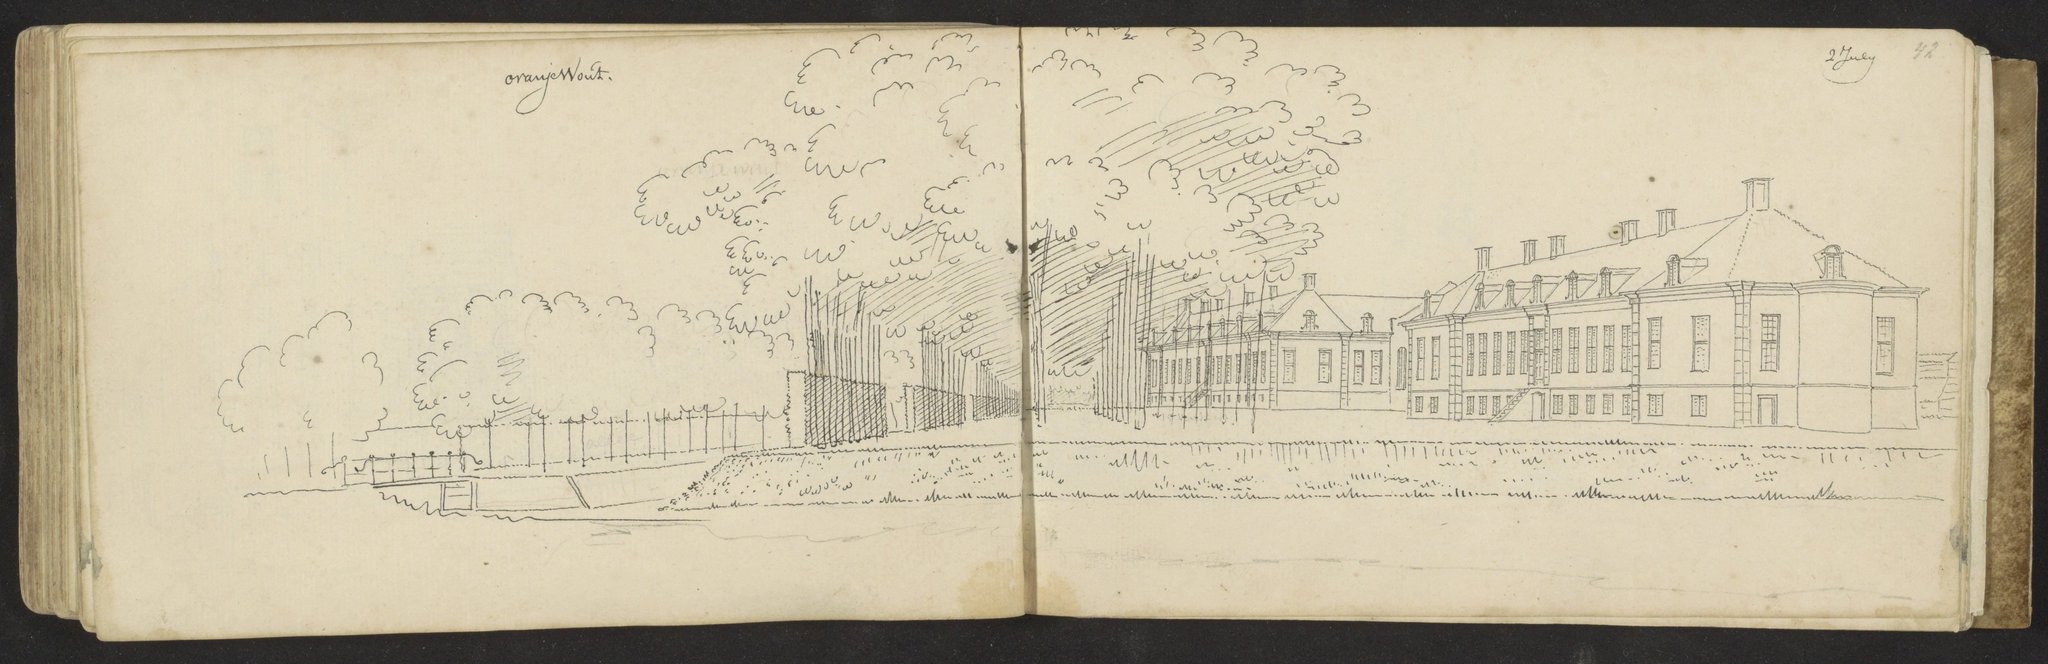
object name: sketchbook leaf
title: Gezicht op landgoed Oranjewoud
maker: abraham de haen (ii)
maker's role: draughtsman, print maker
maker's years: 1707-1748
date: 1732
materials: ink, paper, pencil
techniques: pen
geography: oranjewoud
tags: country-house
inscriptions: date and inscription: ‘oranjewout/ 2 Julij’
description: Blad 41 verso en 42 recto uit een schetsboek met 51 bladen.